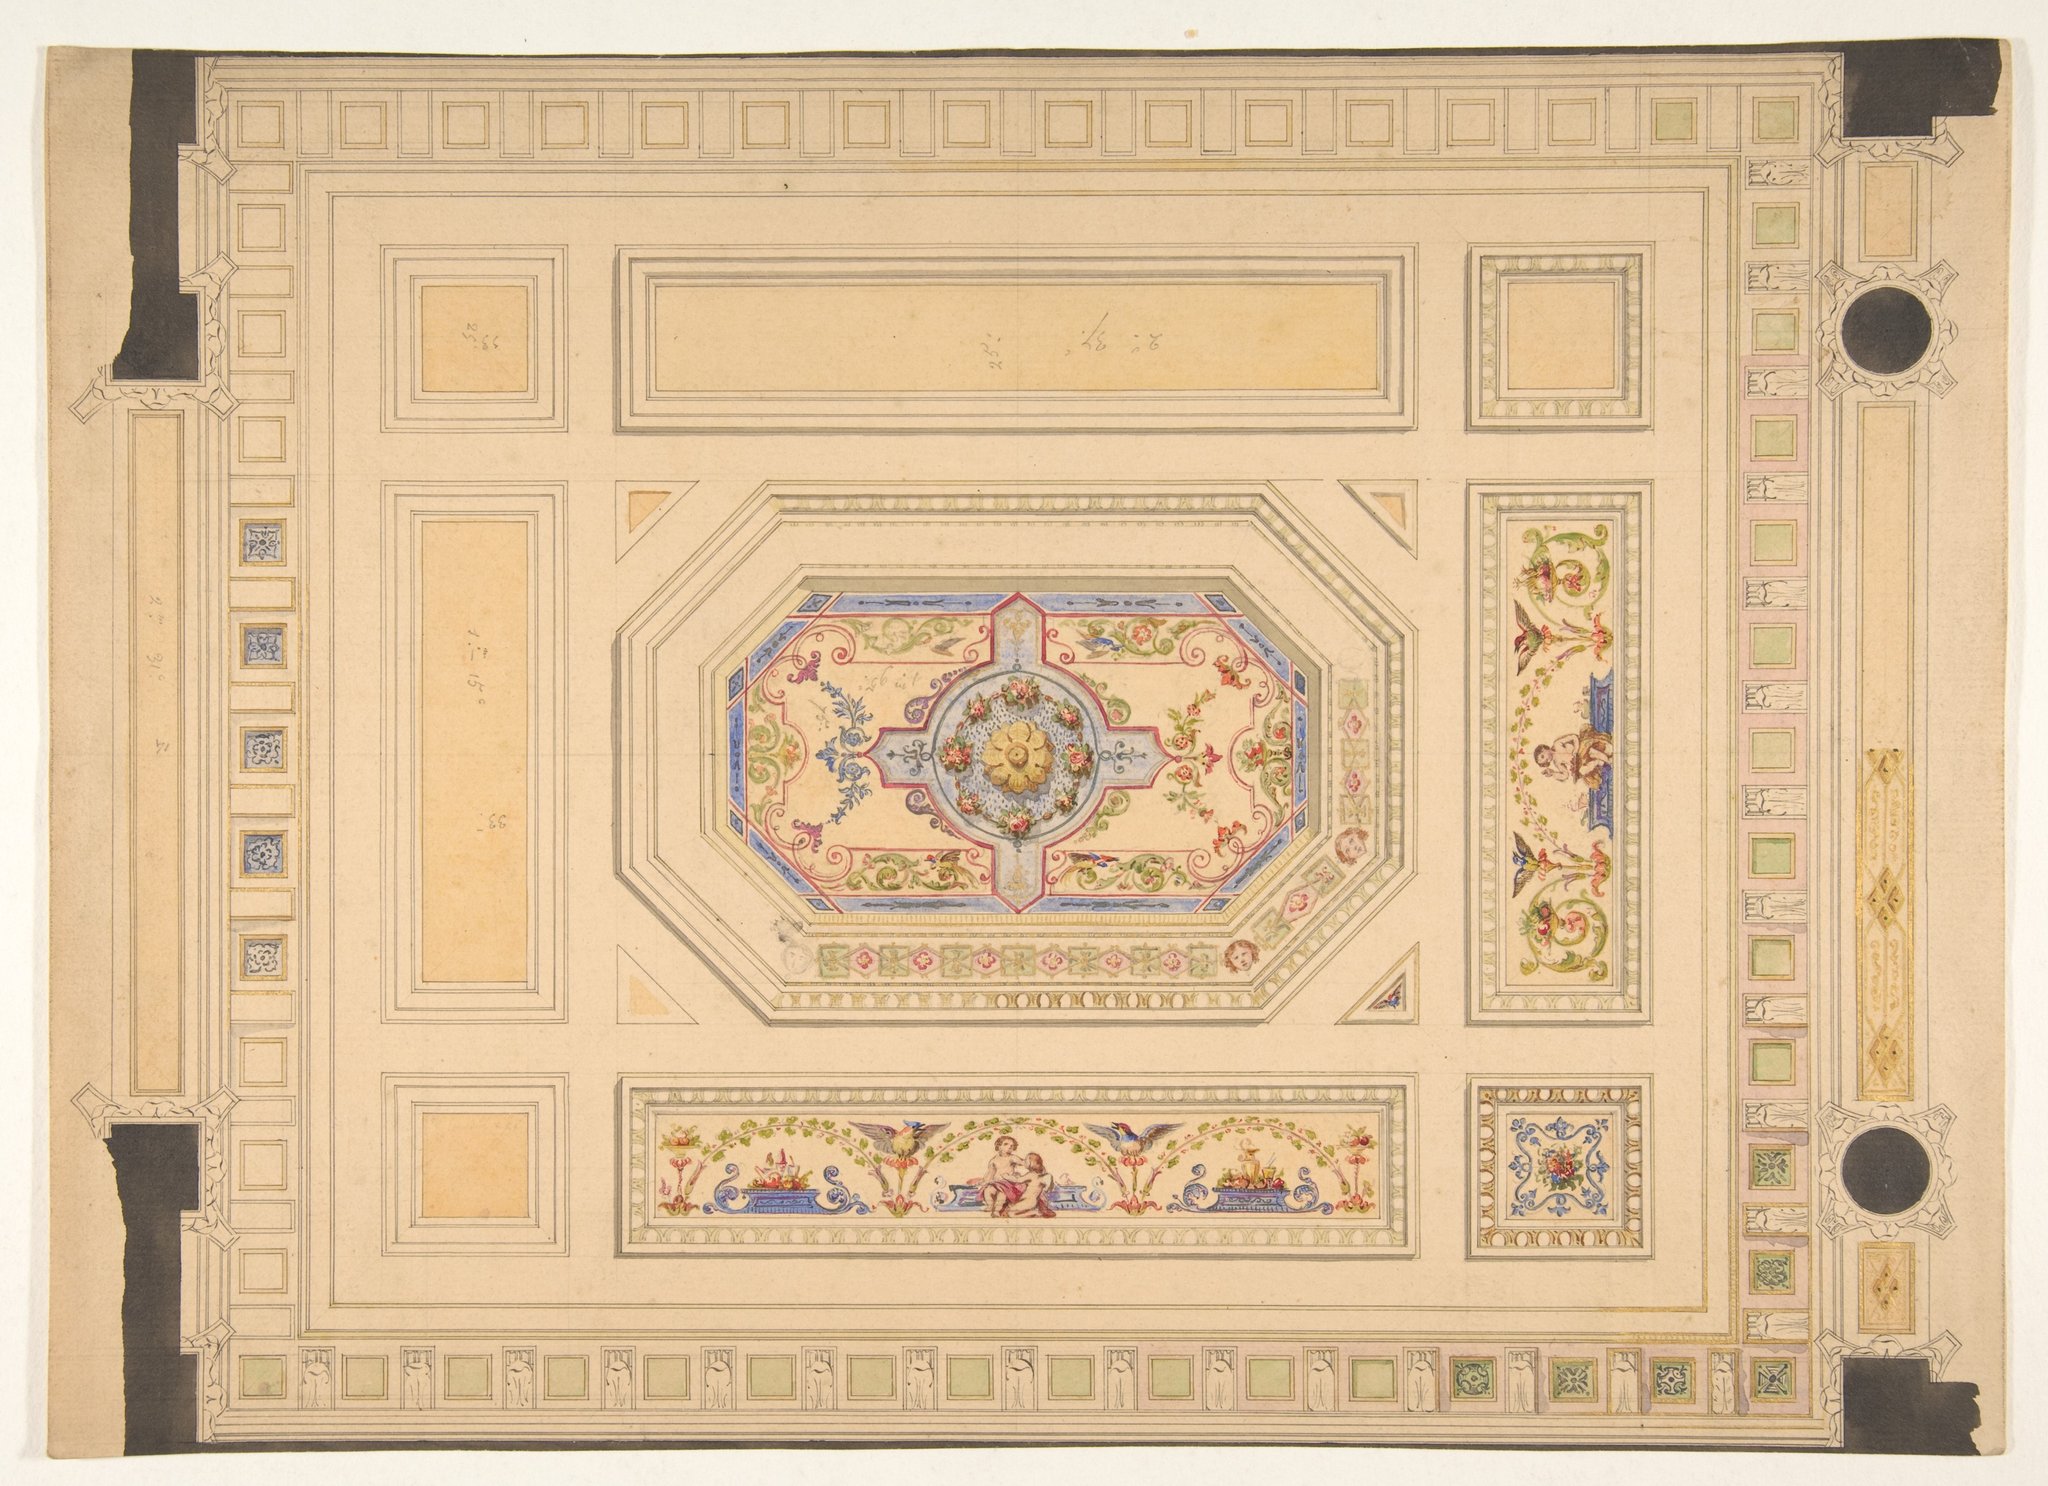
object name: drawing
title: Design for a paneled ceiling painted with putti, birds, and floral motifs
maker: jules-edmond-charles lachaise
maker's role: artist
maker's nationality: french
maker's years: 1897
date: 1801-1900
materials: gold paint, graphite, ink, paper, watercolor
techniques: pen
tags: architecture,ceilings